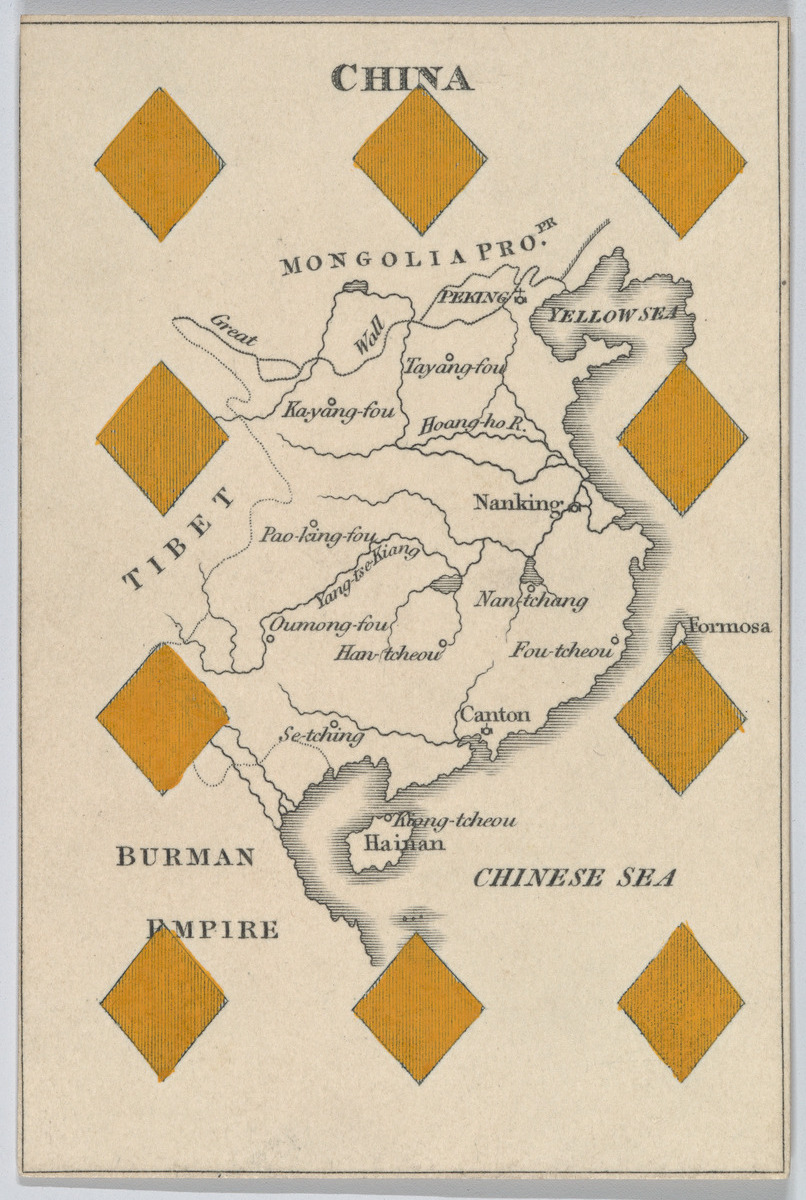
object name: print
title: China in Asia, from "Court Game of Geography"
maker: william and henry rock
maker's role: publisher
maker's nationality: british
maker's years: 1821-1884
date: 1838-1855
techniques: engraving, hand coloring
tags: playing cards,maps